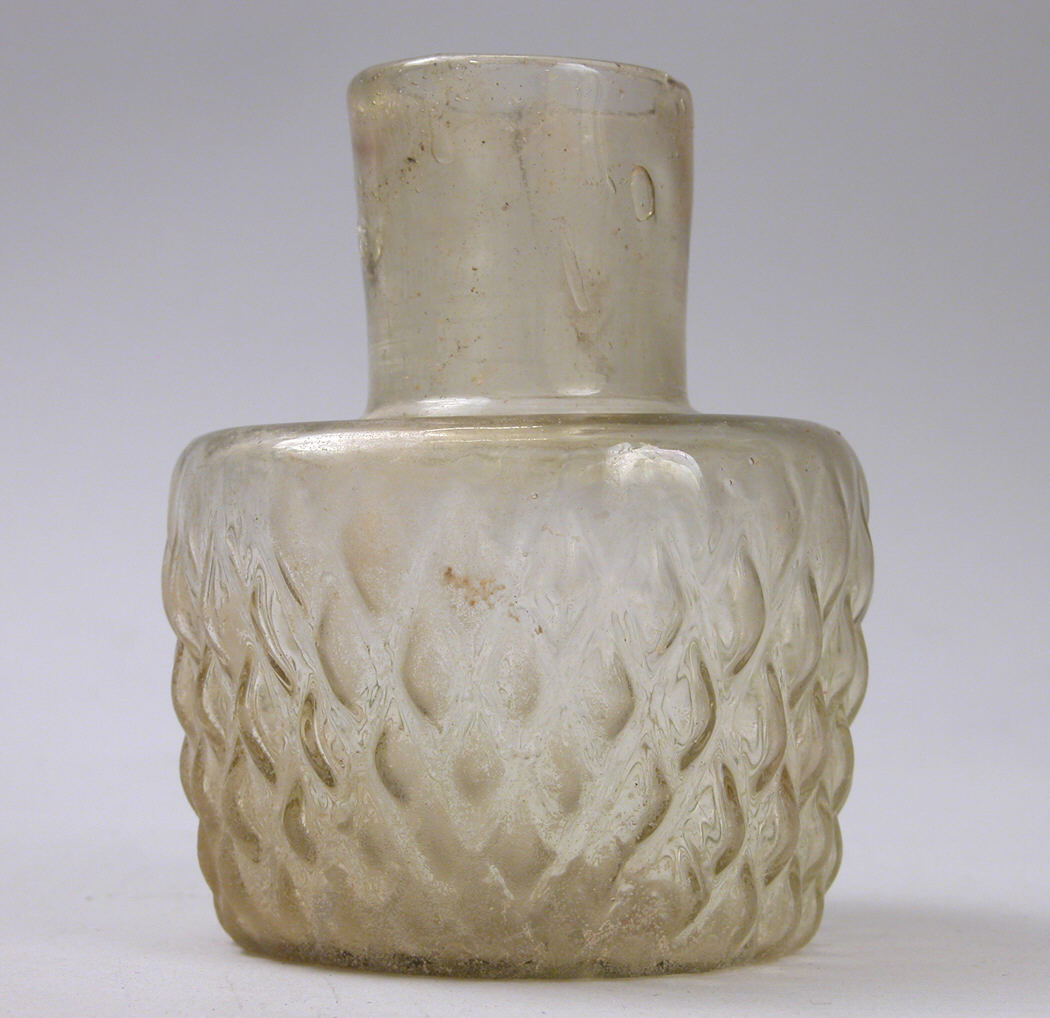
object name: bottle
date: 901-1100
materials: glass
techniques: glassblowing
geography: iran